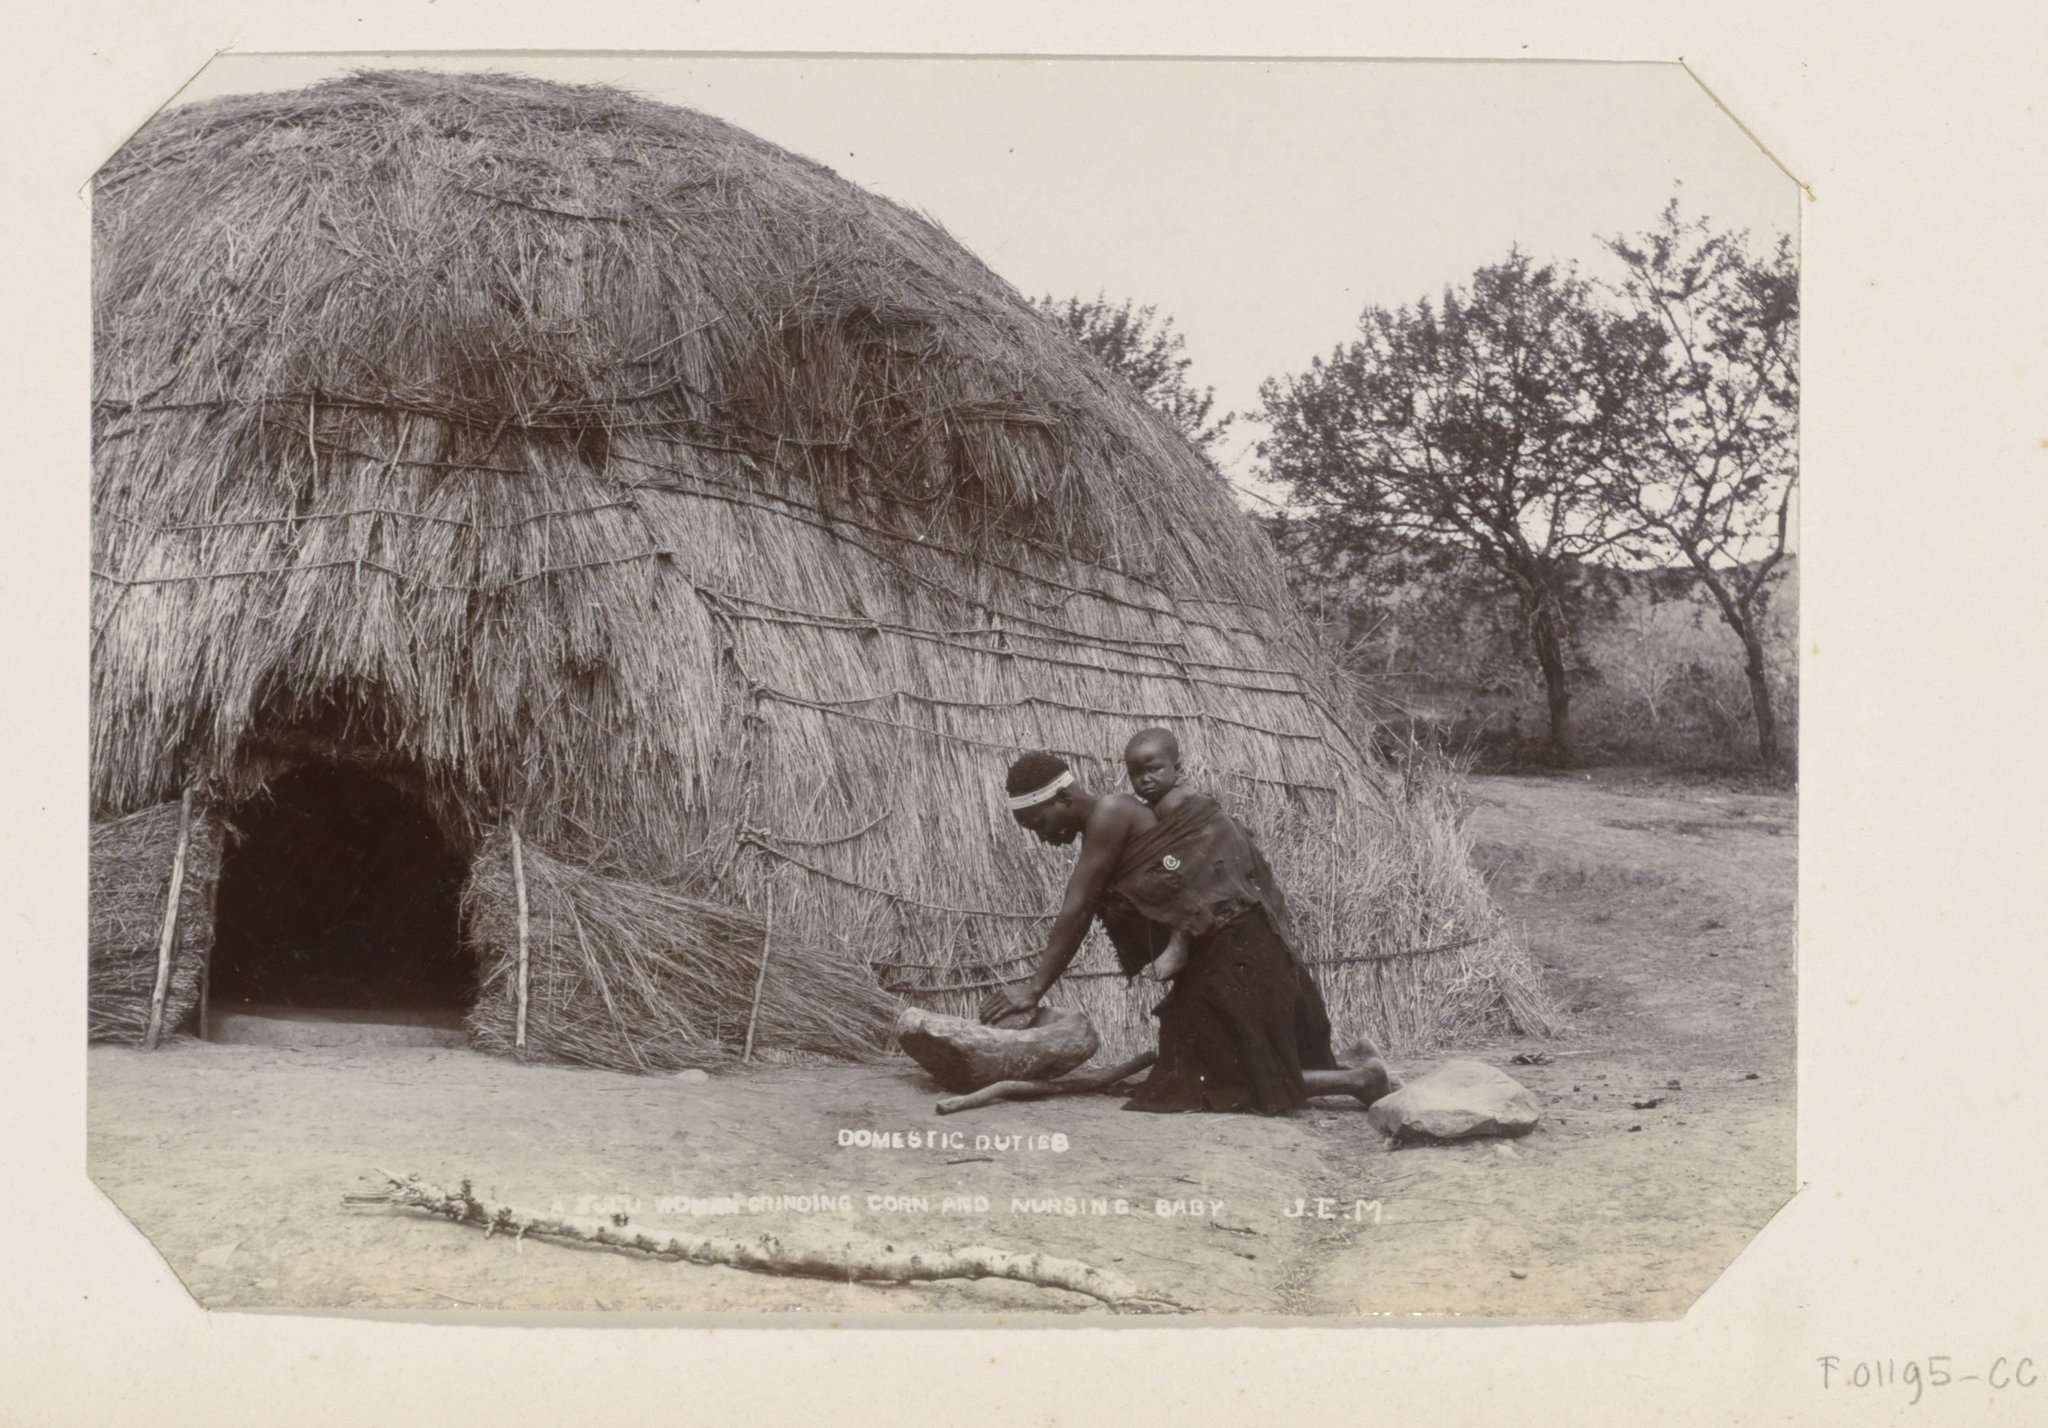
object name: photograph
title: Zoeloevrouw met baby op de rug maalt graan met de hand in Zuid-Afrika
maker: jem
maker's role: fotograaf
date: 1880-1910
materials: cardboard, paper, photographic support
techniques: gelatin silver print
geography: south africa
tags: mother and baby or young child, hut, cabin, lodge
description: Onderdeel van Fotoalbum van een reis door de Verenigde Staten, Honolulu, Nederlands-Indië, Aden, Zanzibar en Zuidelijk Afrika.